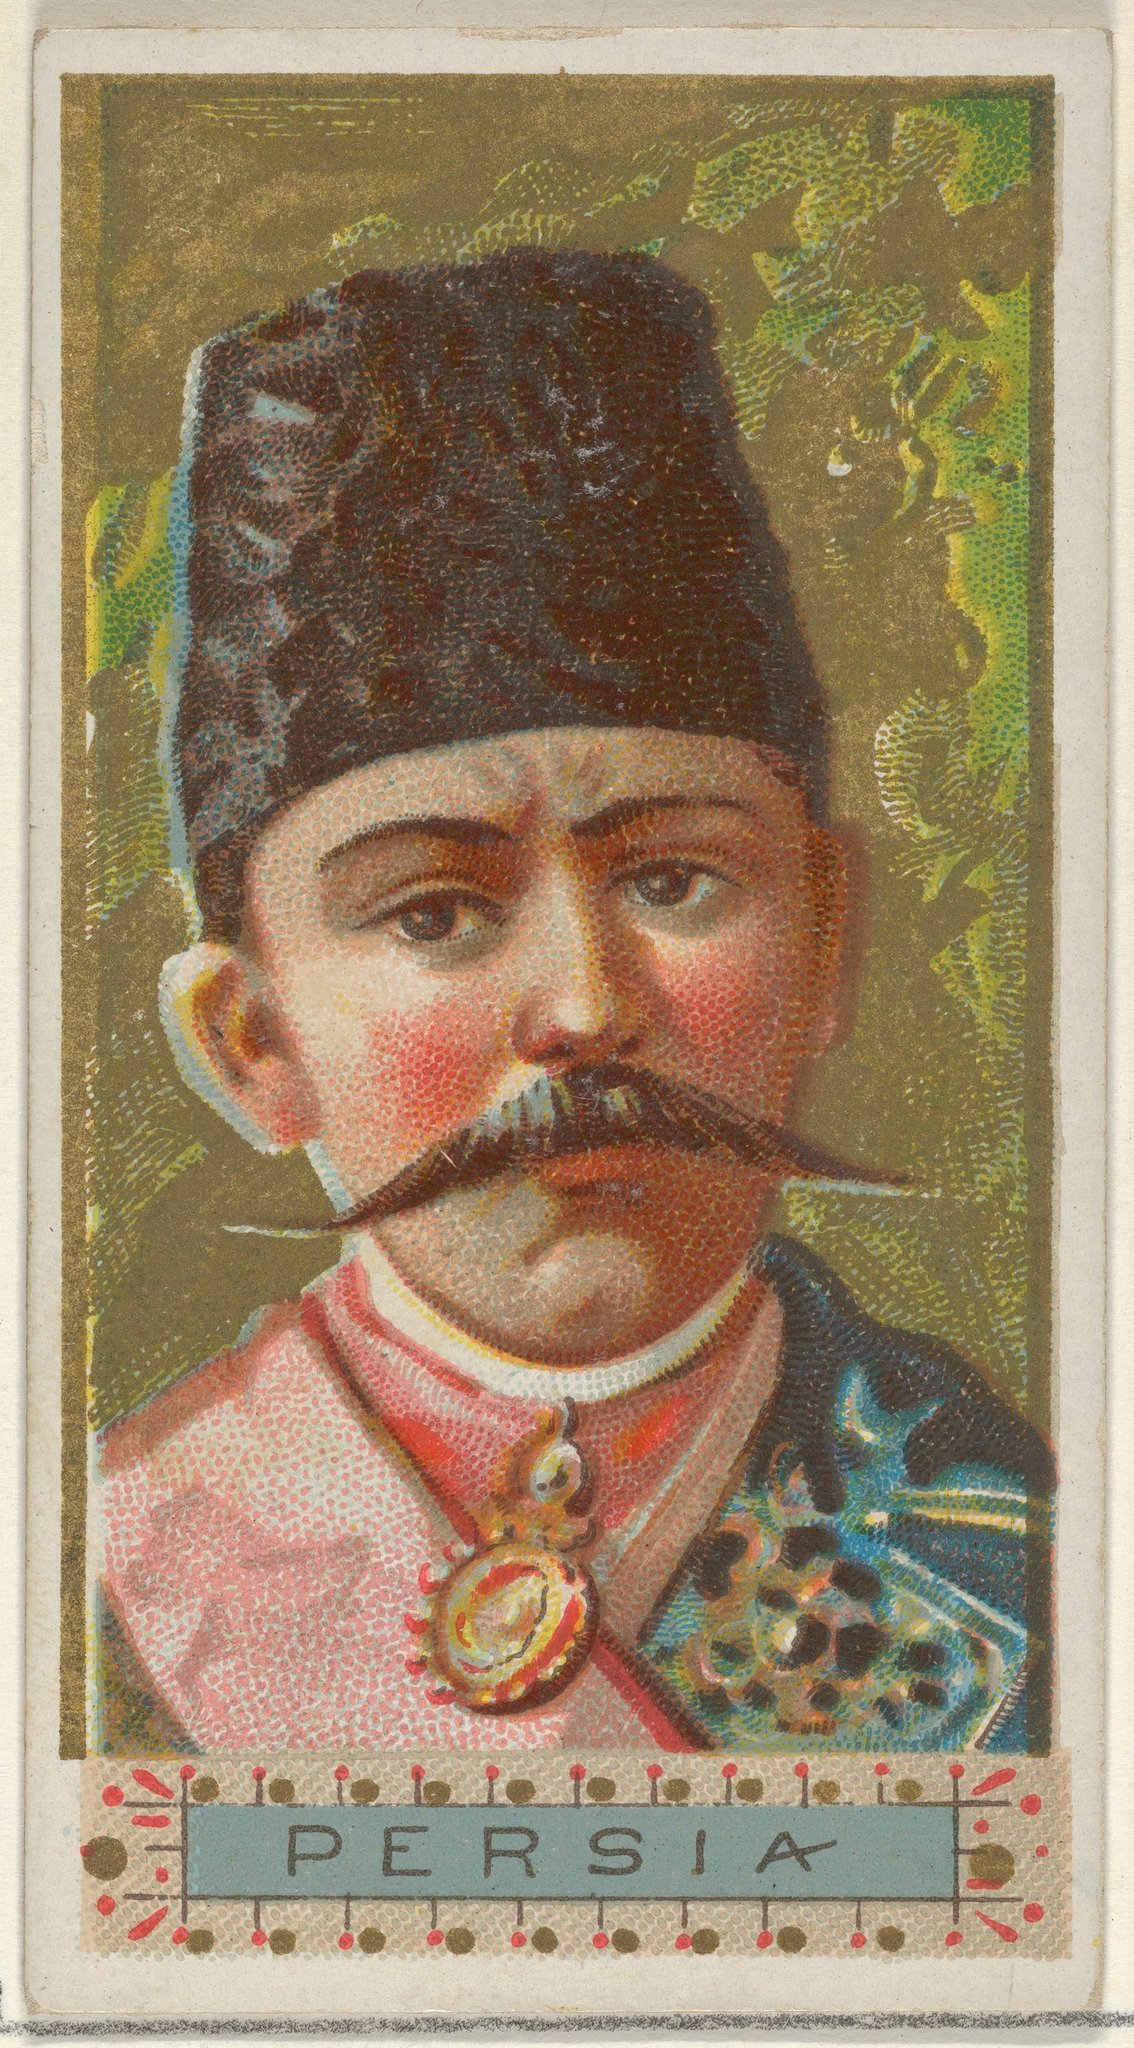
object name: print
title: Persia, from the Types of All Nations series (N24) for Allen & Ginter Cigarettes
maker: allen & ginter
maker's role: publisher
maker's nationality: american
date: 1889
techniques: color lithograph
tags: men